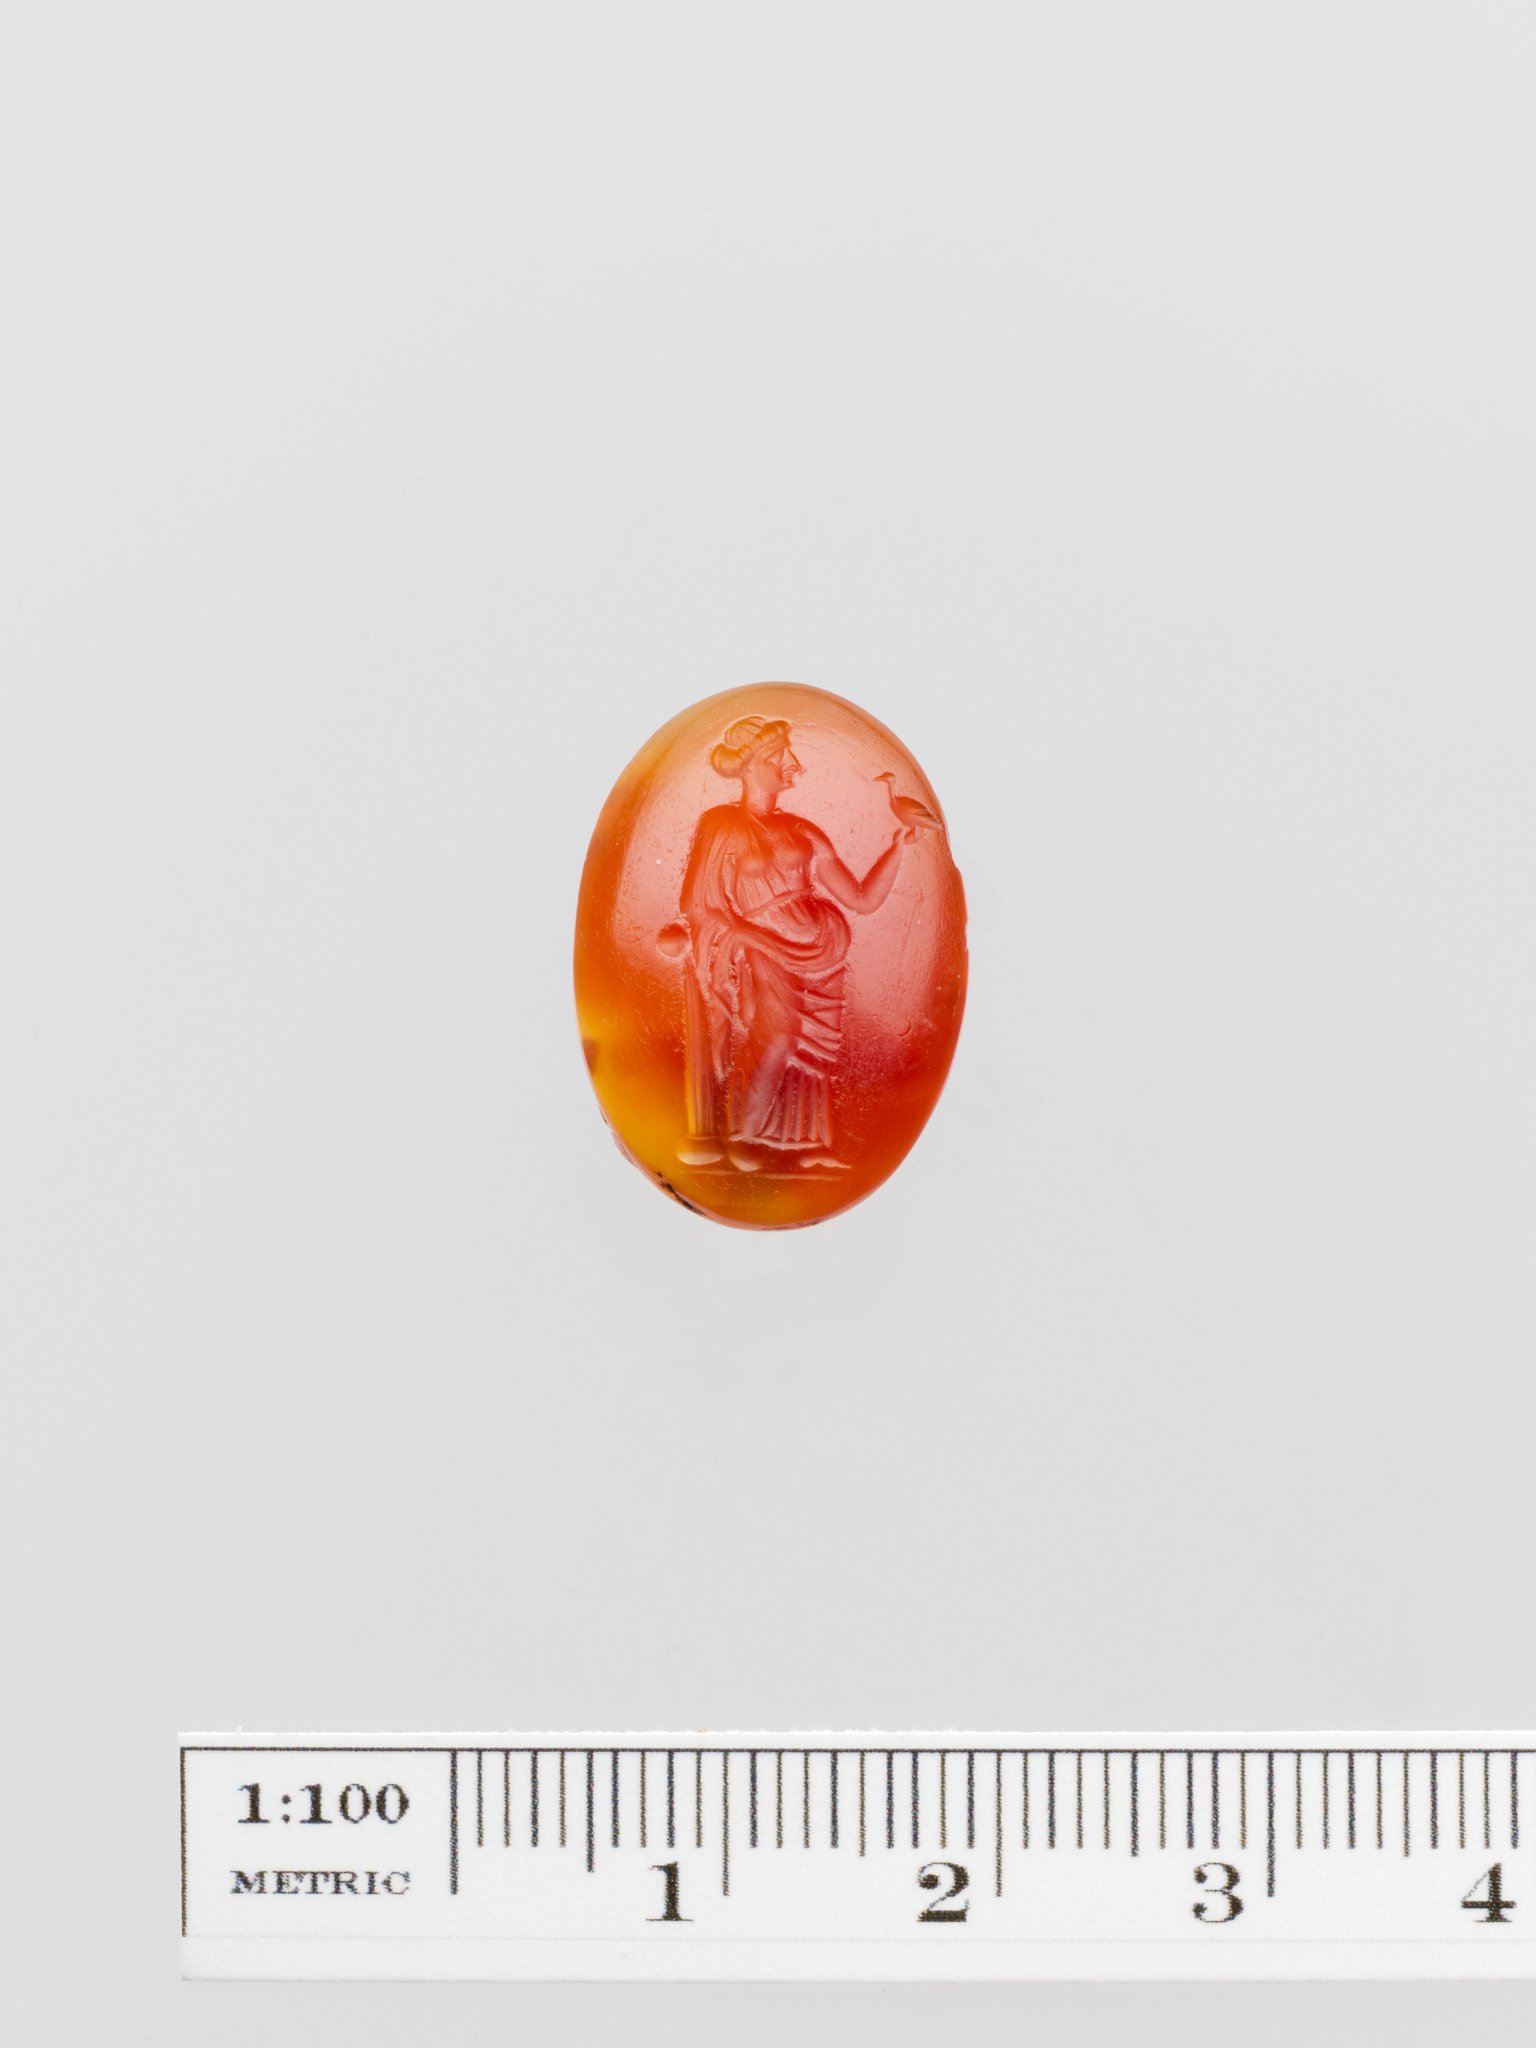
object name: intaglio of woman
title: Carnelian oval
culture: greek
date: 200-1 BCE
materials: gemstone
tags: doves,women